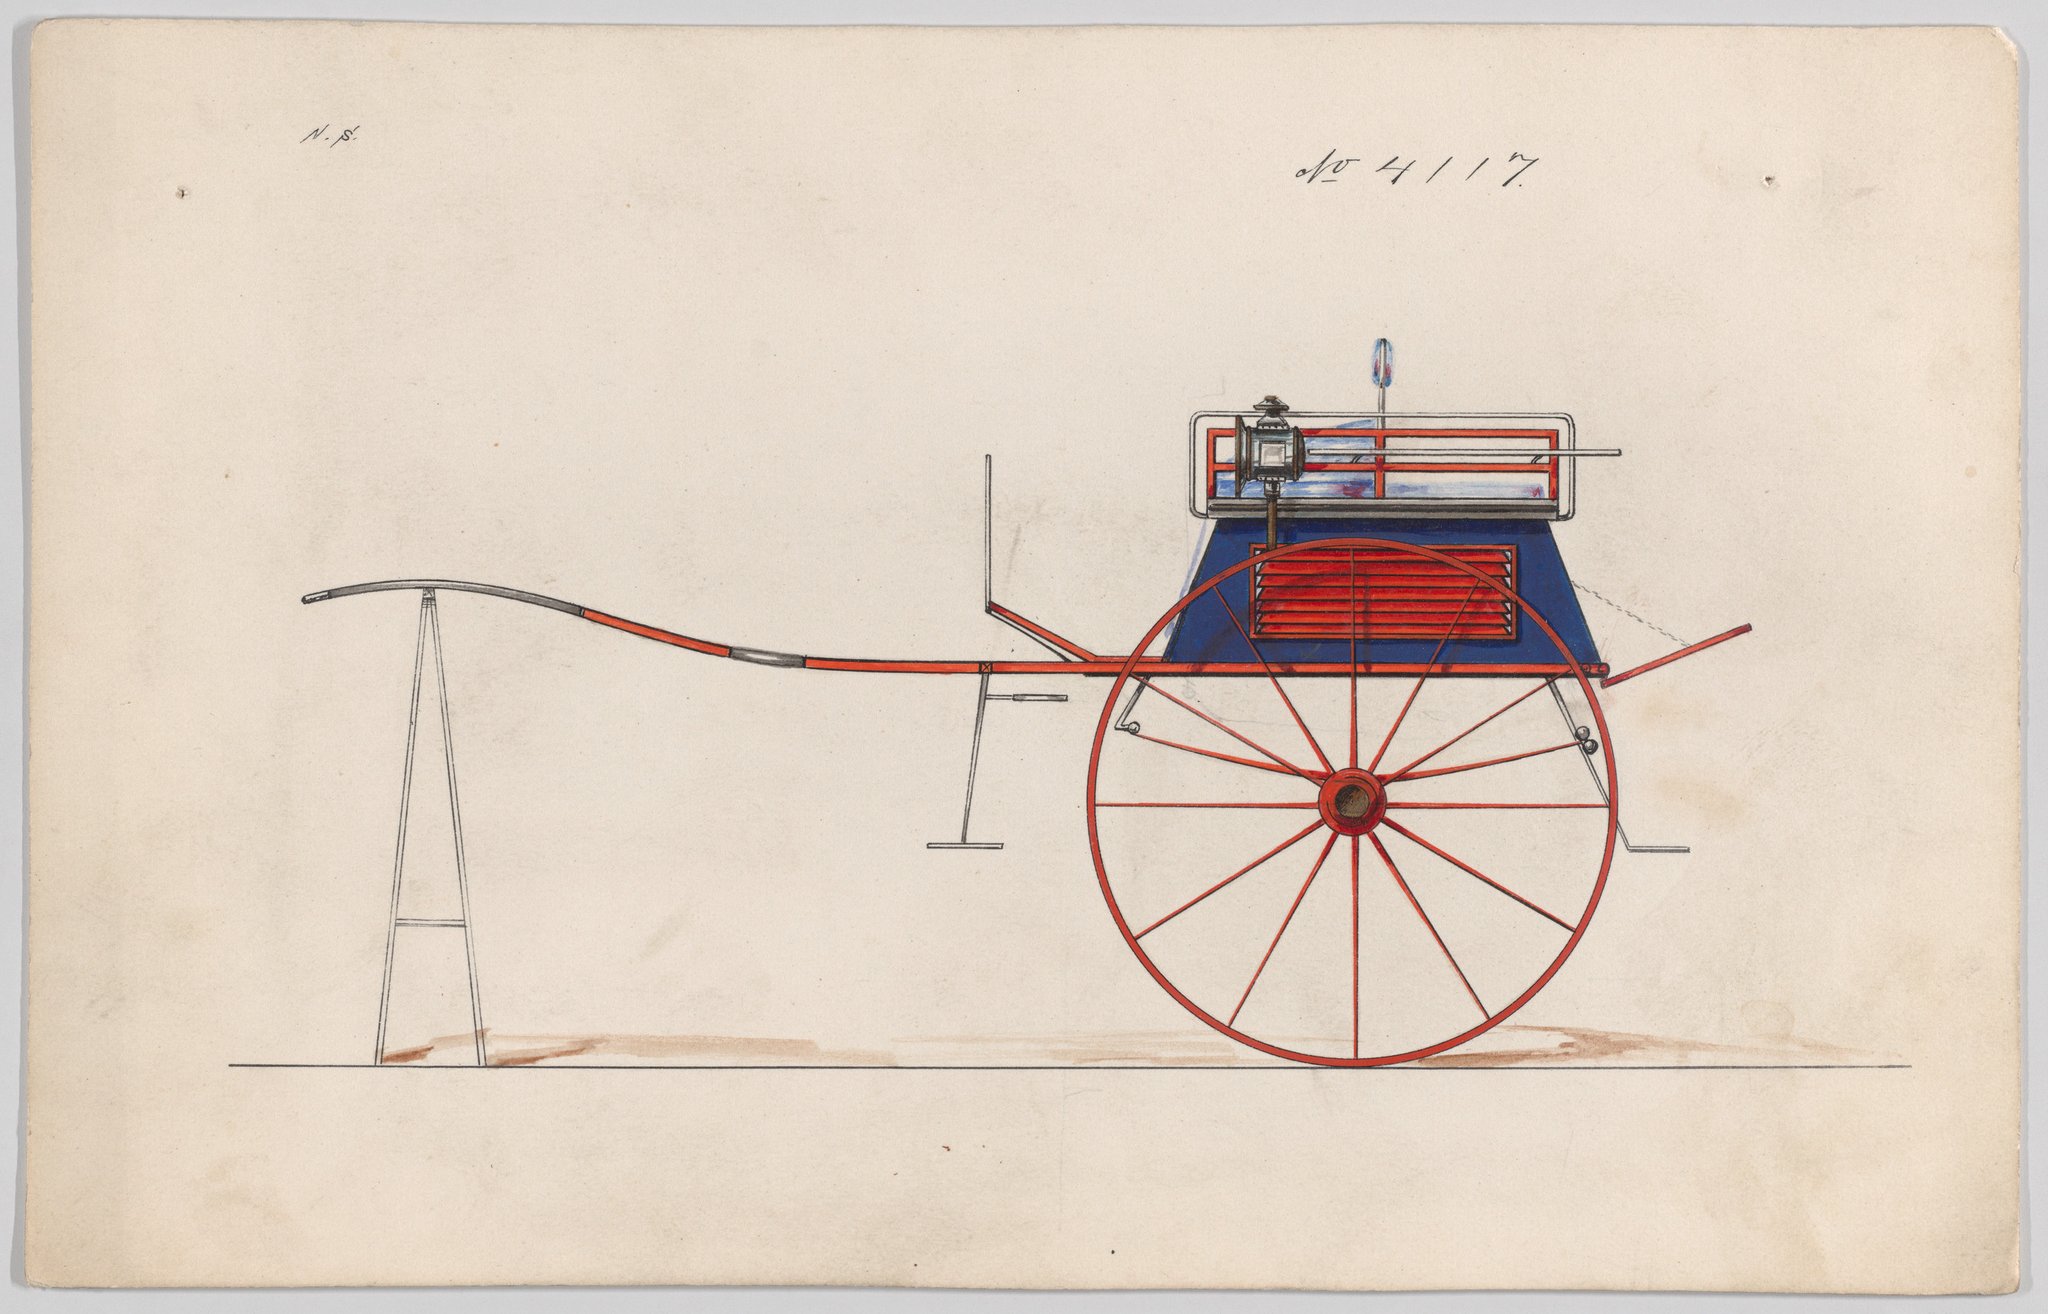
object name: drawing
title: Design for Dog Cart or 2 Wheeler, no. 4117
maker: brewster & co.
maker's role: manufacturer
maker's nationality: american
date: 1891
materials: gouache, gum arabic, ink, watercolor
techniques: pen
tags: carriages